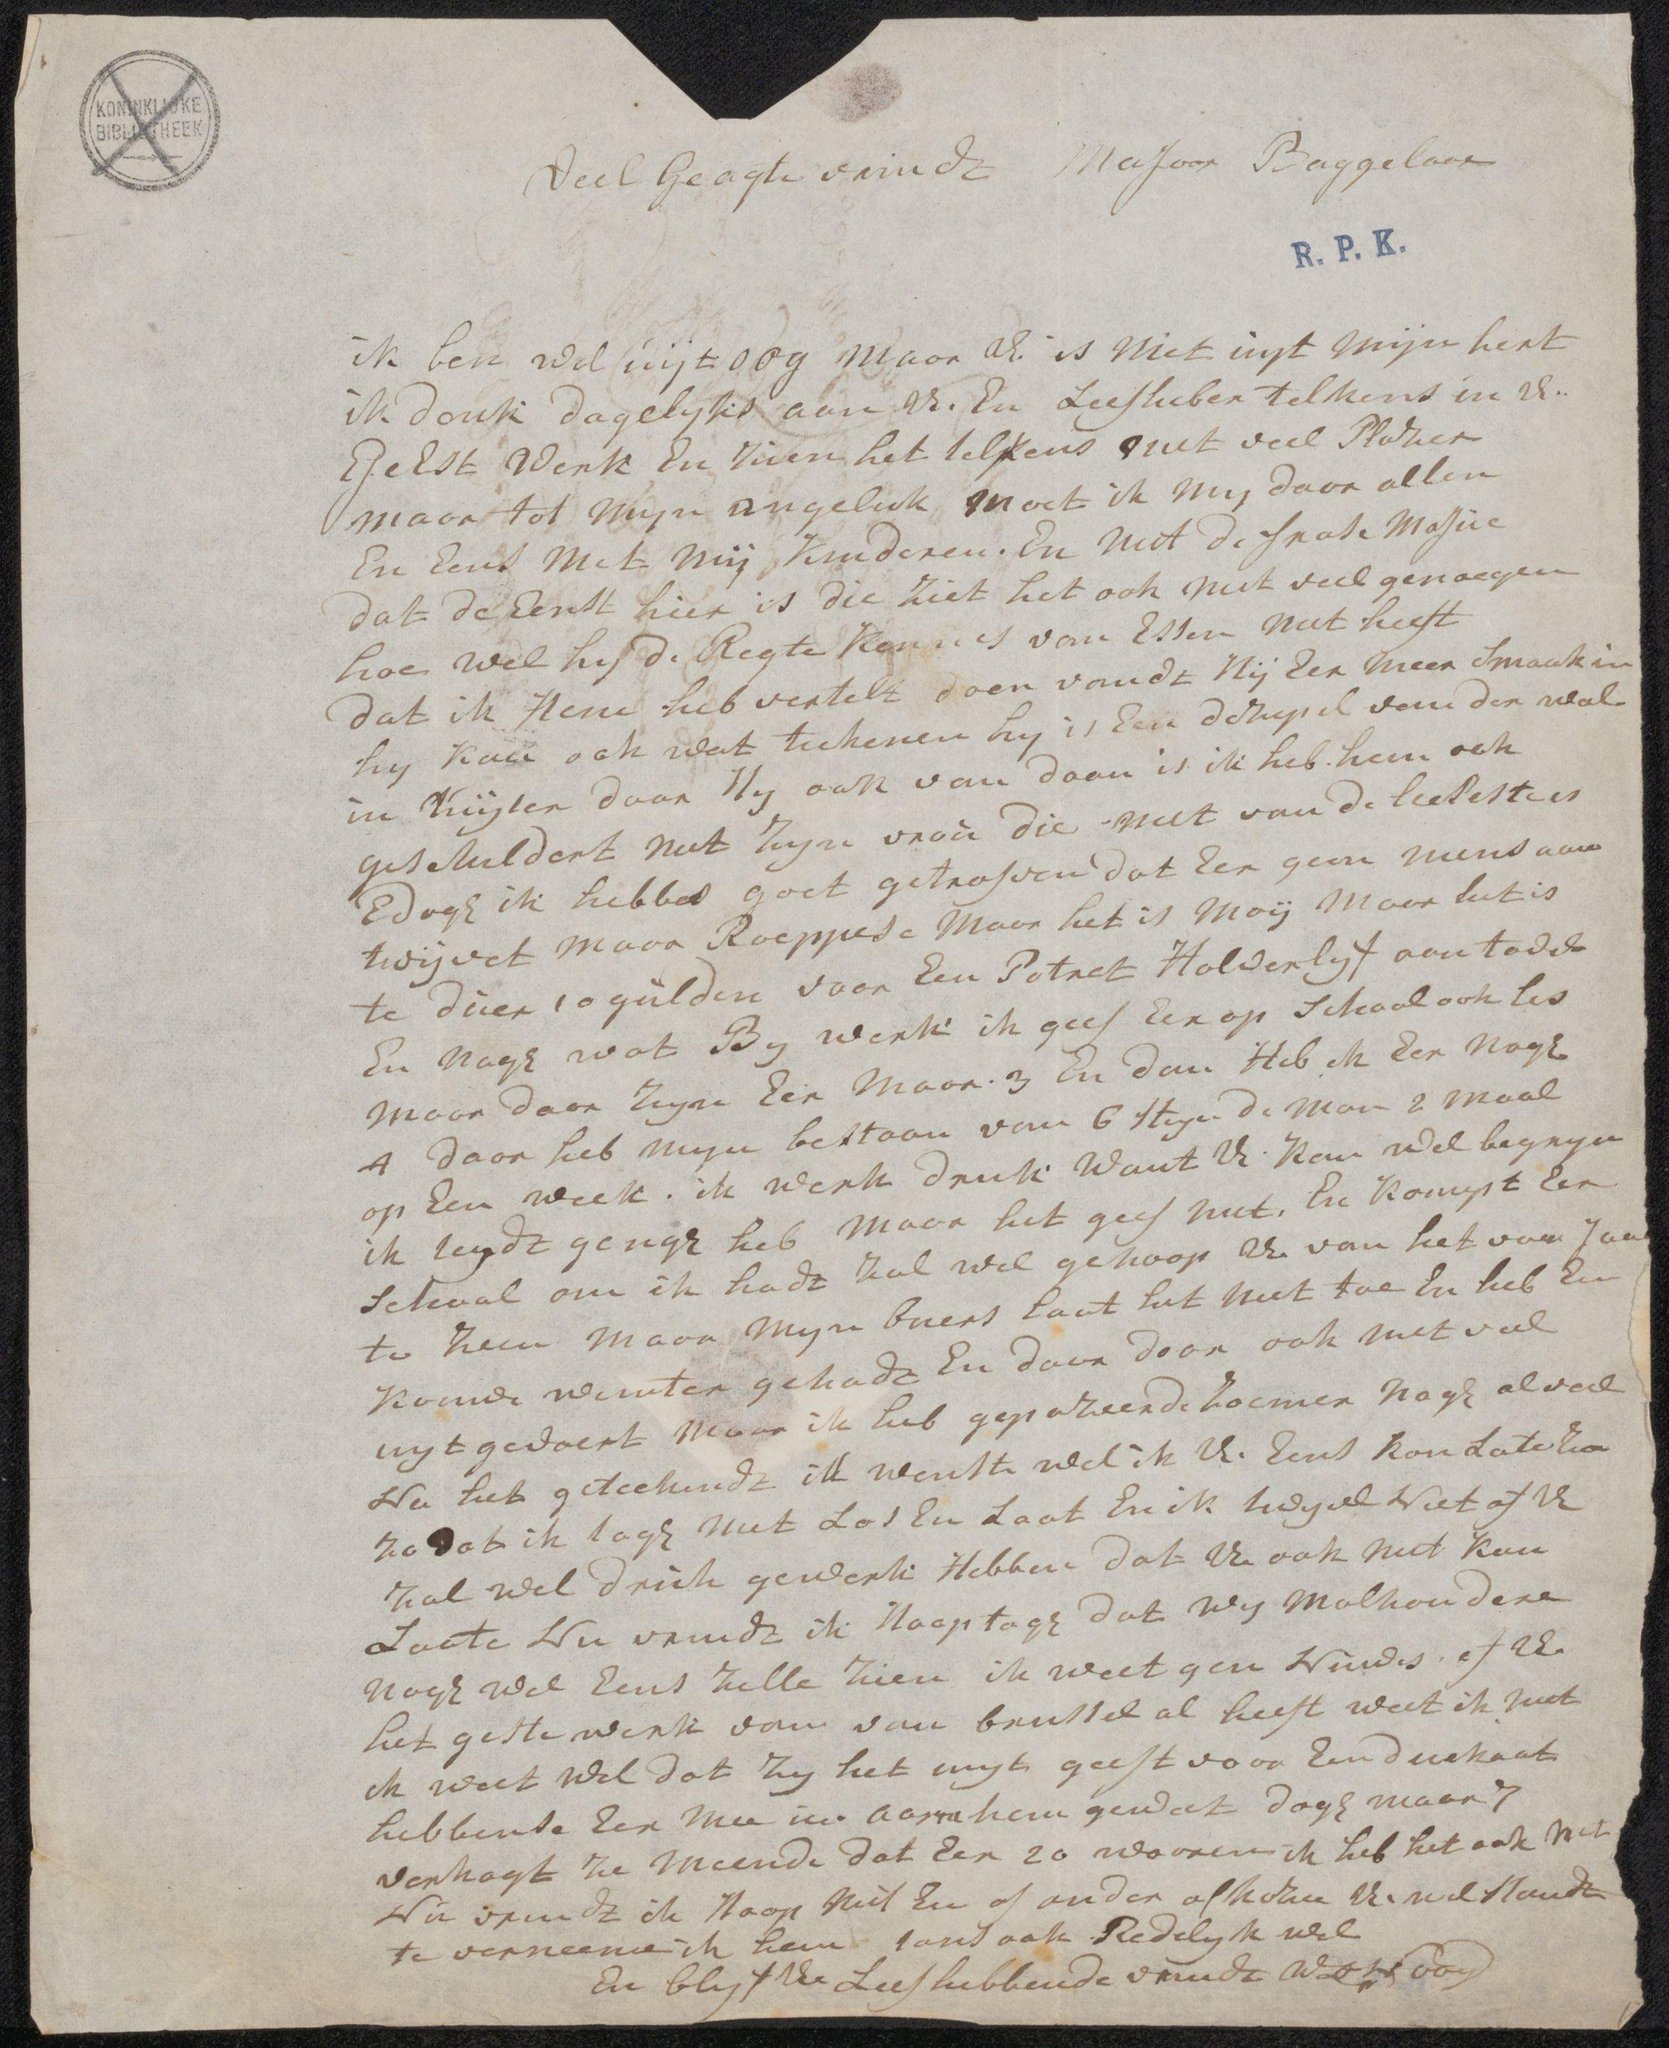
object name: letter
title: Brief aan Ernst Willem Jan Bagelaar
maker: wouterus de nooy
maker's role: draughtsman, painter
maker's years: 1758-1826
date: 1768-1826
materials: ink, paper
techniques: pen, writing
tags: print maker, draughtsman, ernst willem jan bagelaar, the graphic arts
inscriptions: collector's mark: ‘KONINKLIJKE/ BIBLIOTHEEK’, collector's mark: Lugt 2233, seal